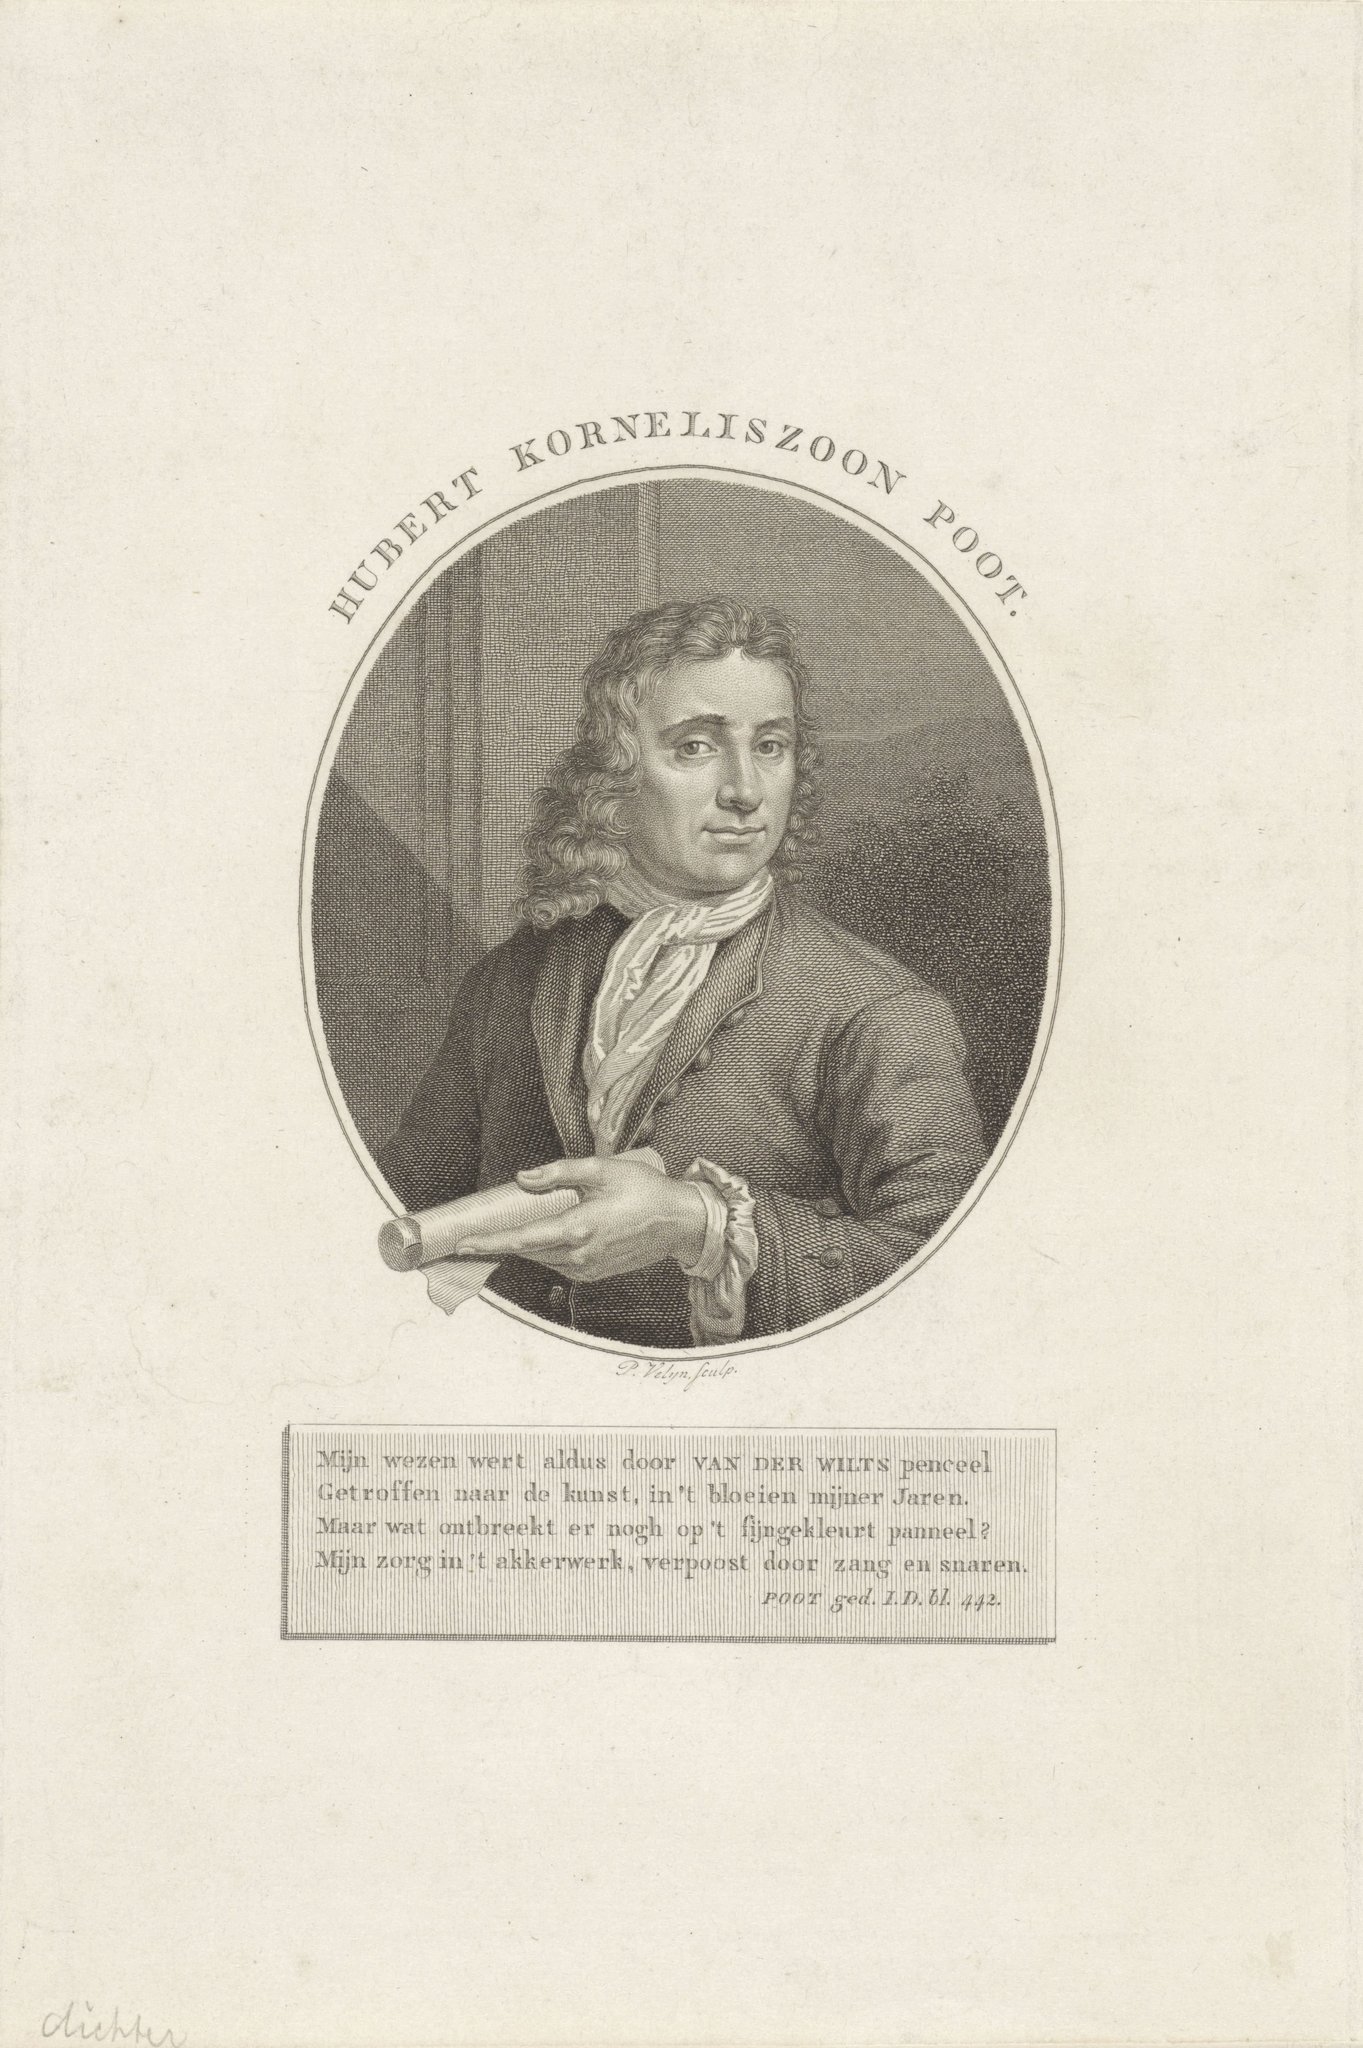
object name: print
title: Portret van Hubert Korneliszoon Poot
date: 1797-1836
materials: paper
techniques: engraving, etching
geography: netherlands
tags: delft, hubert kornelisz. poot, paper (writing material)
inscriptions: collector's mark: Lugt 2228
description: Portret van Hubert Korneliszoon Poot, dichter en landbouwer te Abtswoude. In zijn hand een rol papier.